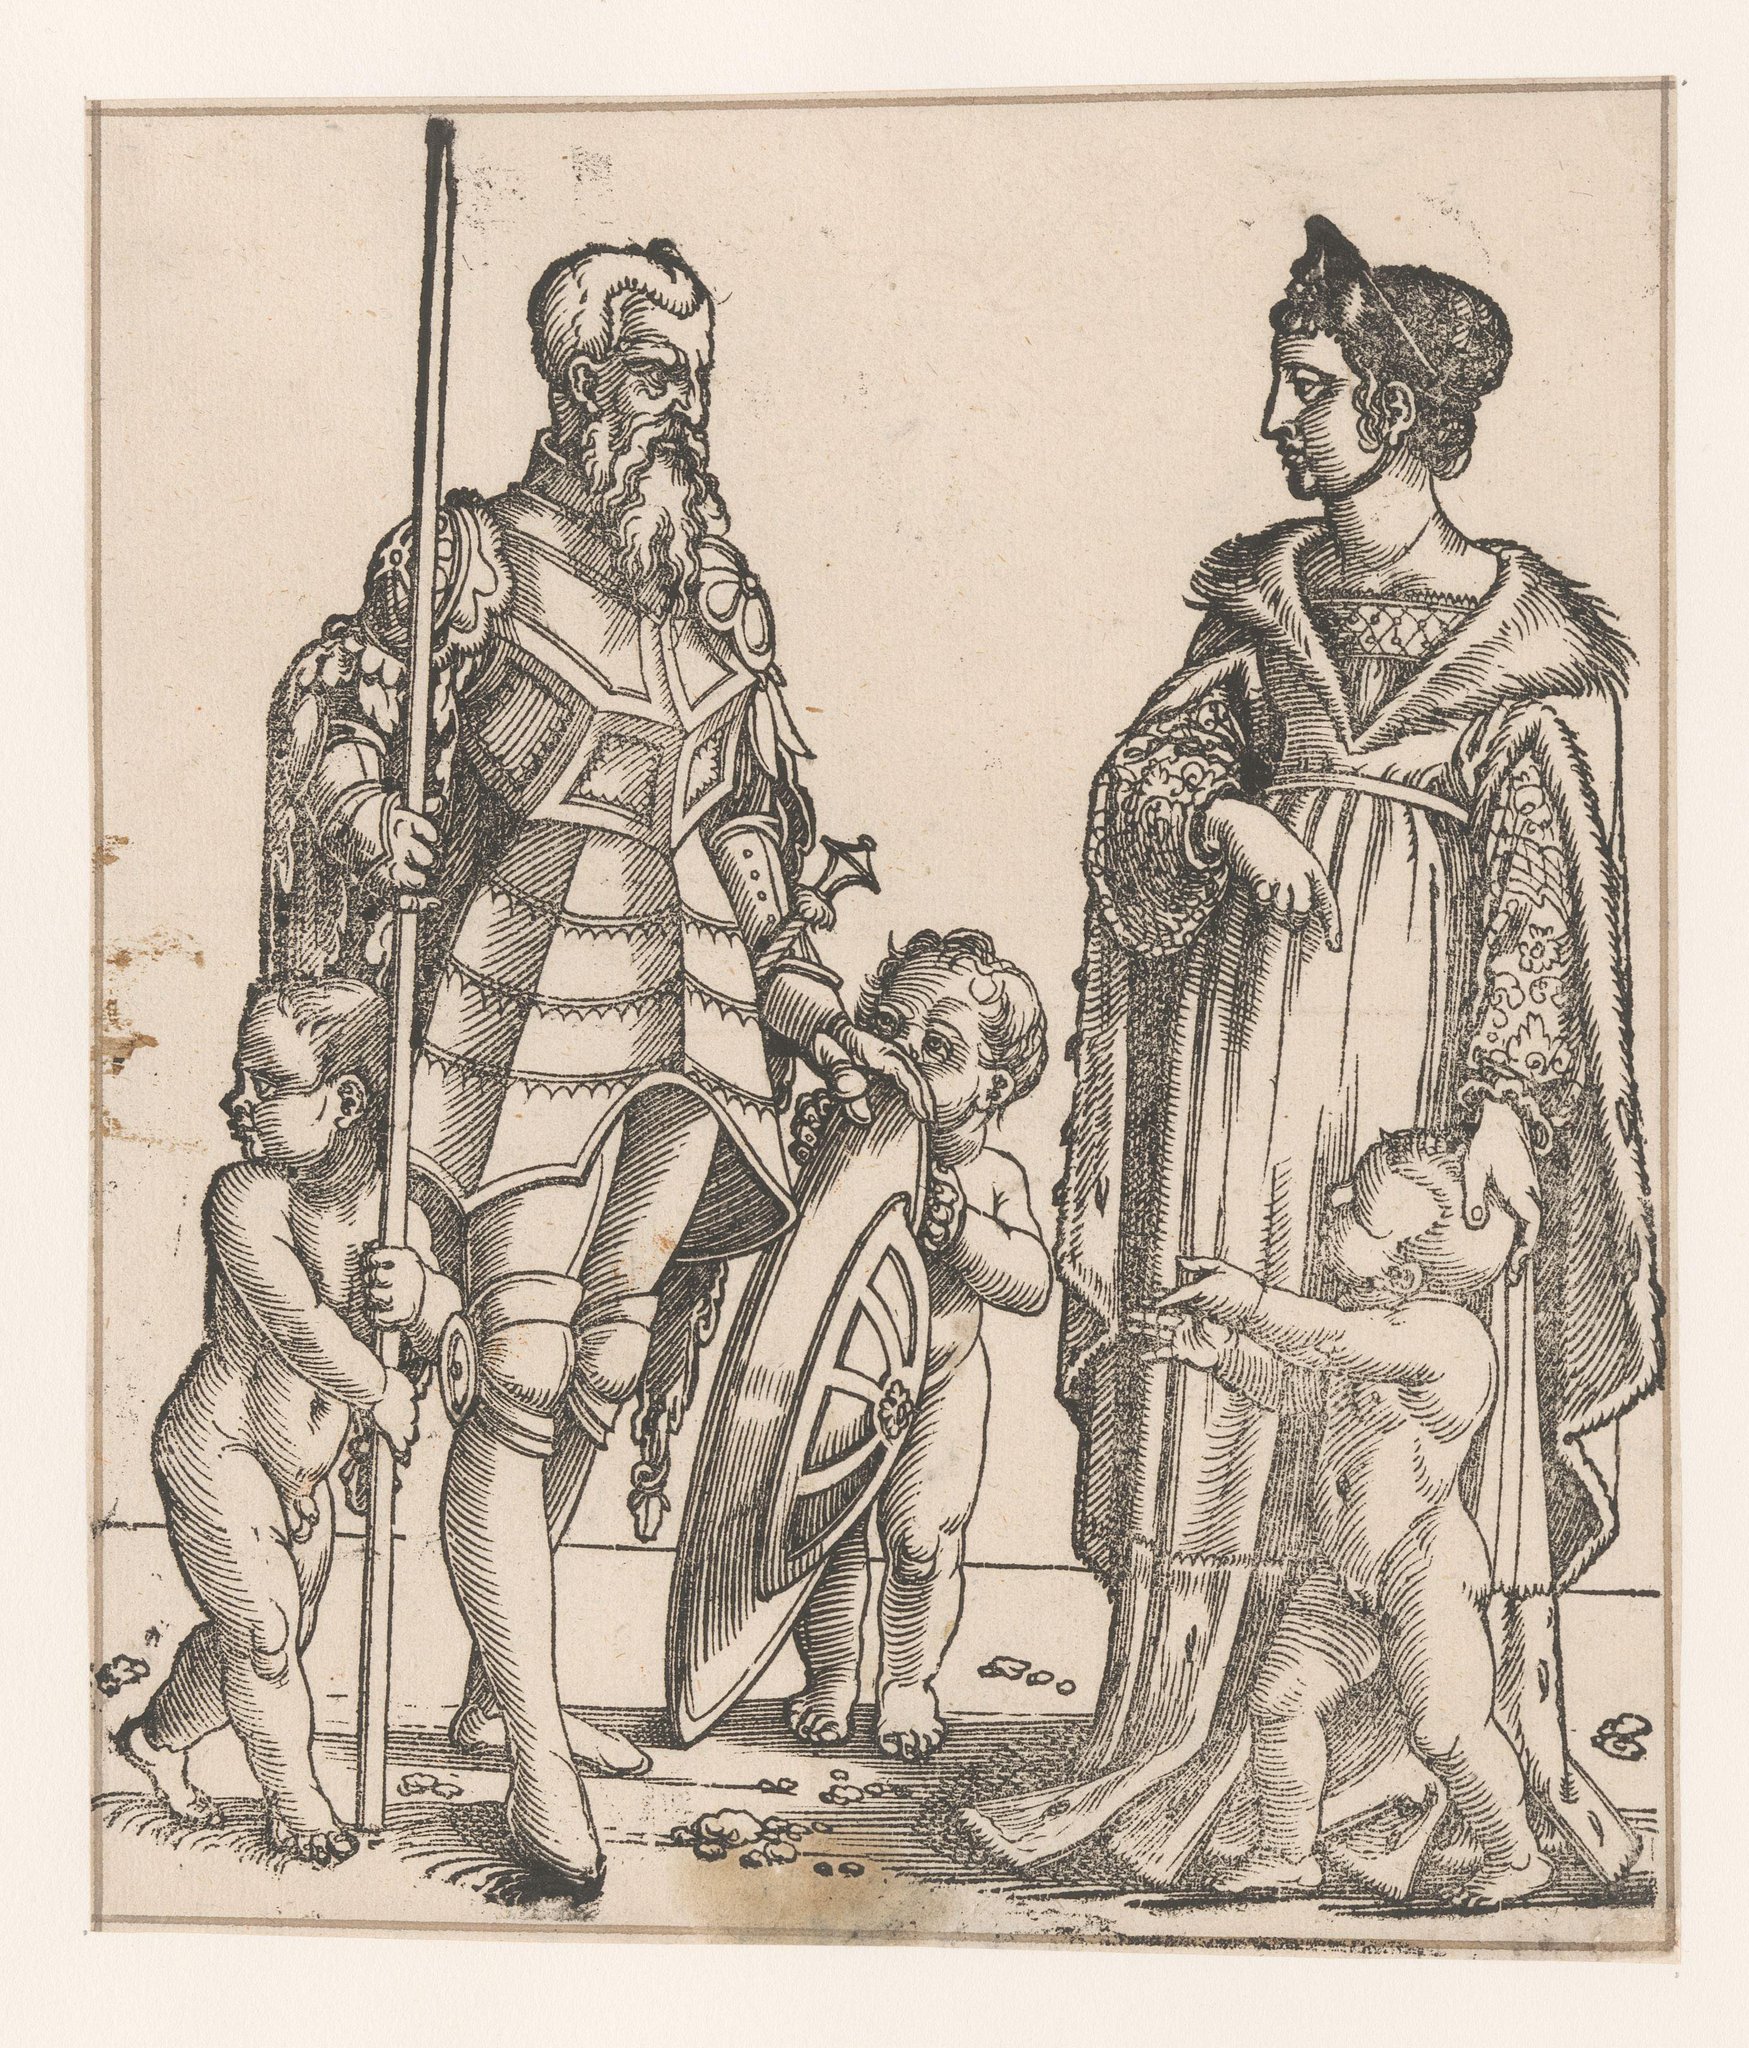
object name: print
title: Patriarchen van het Oude Testament met hun vrouwen en kinderen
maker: Anonymous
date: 1530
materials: paper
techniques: woodcut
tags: male persons from the old testament (mahalalel) (mahalalel)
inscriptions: collector's mark: Lugt 240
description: Onderdeel van een serie van tien houtsnedes met de patriarchen.